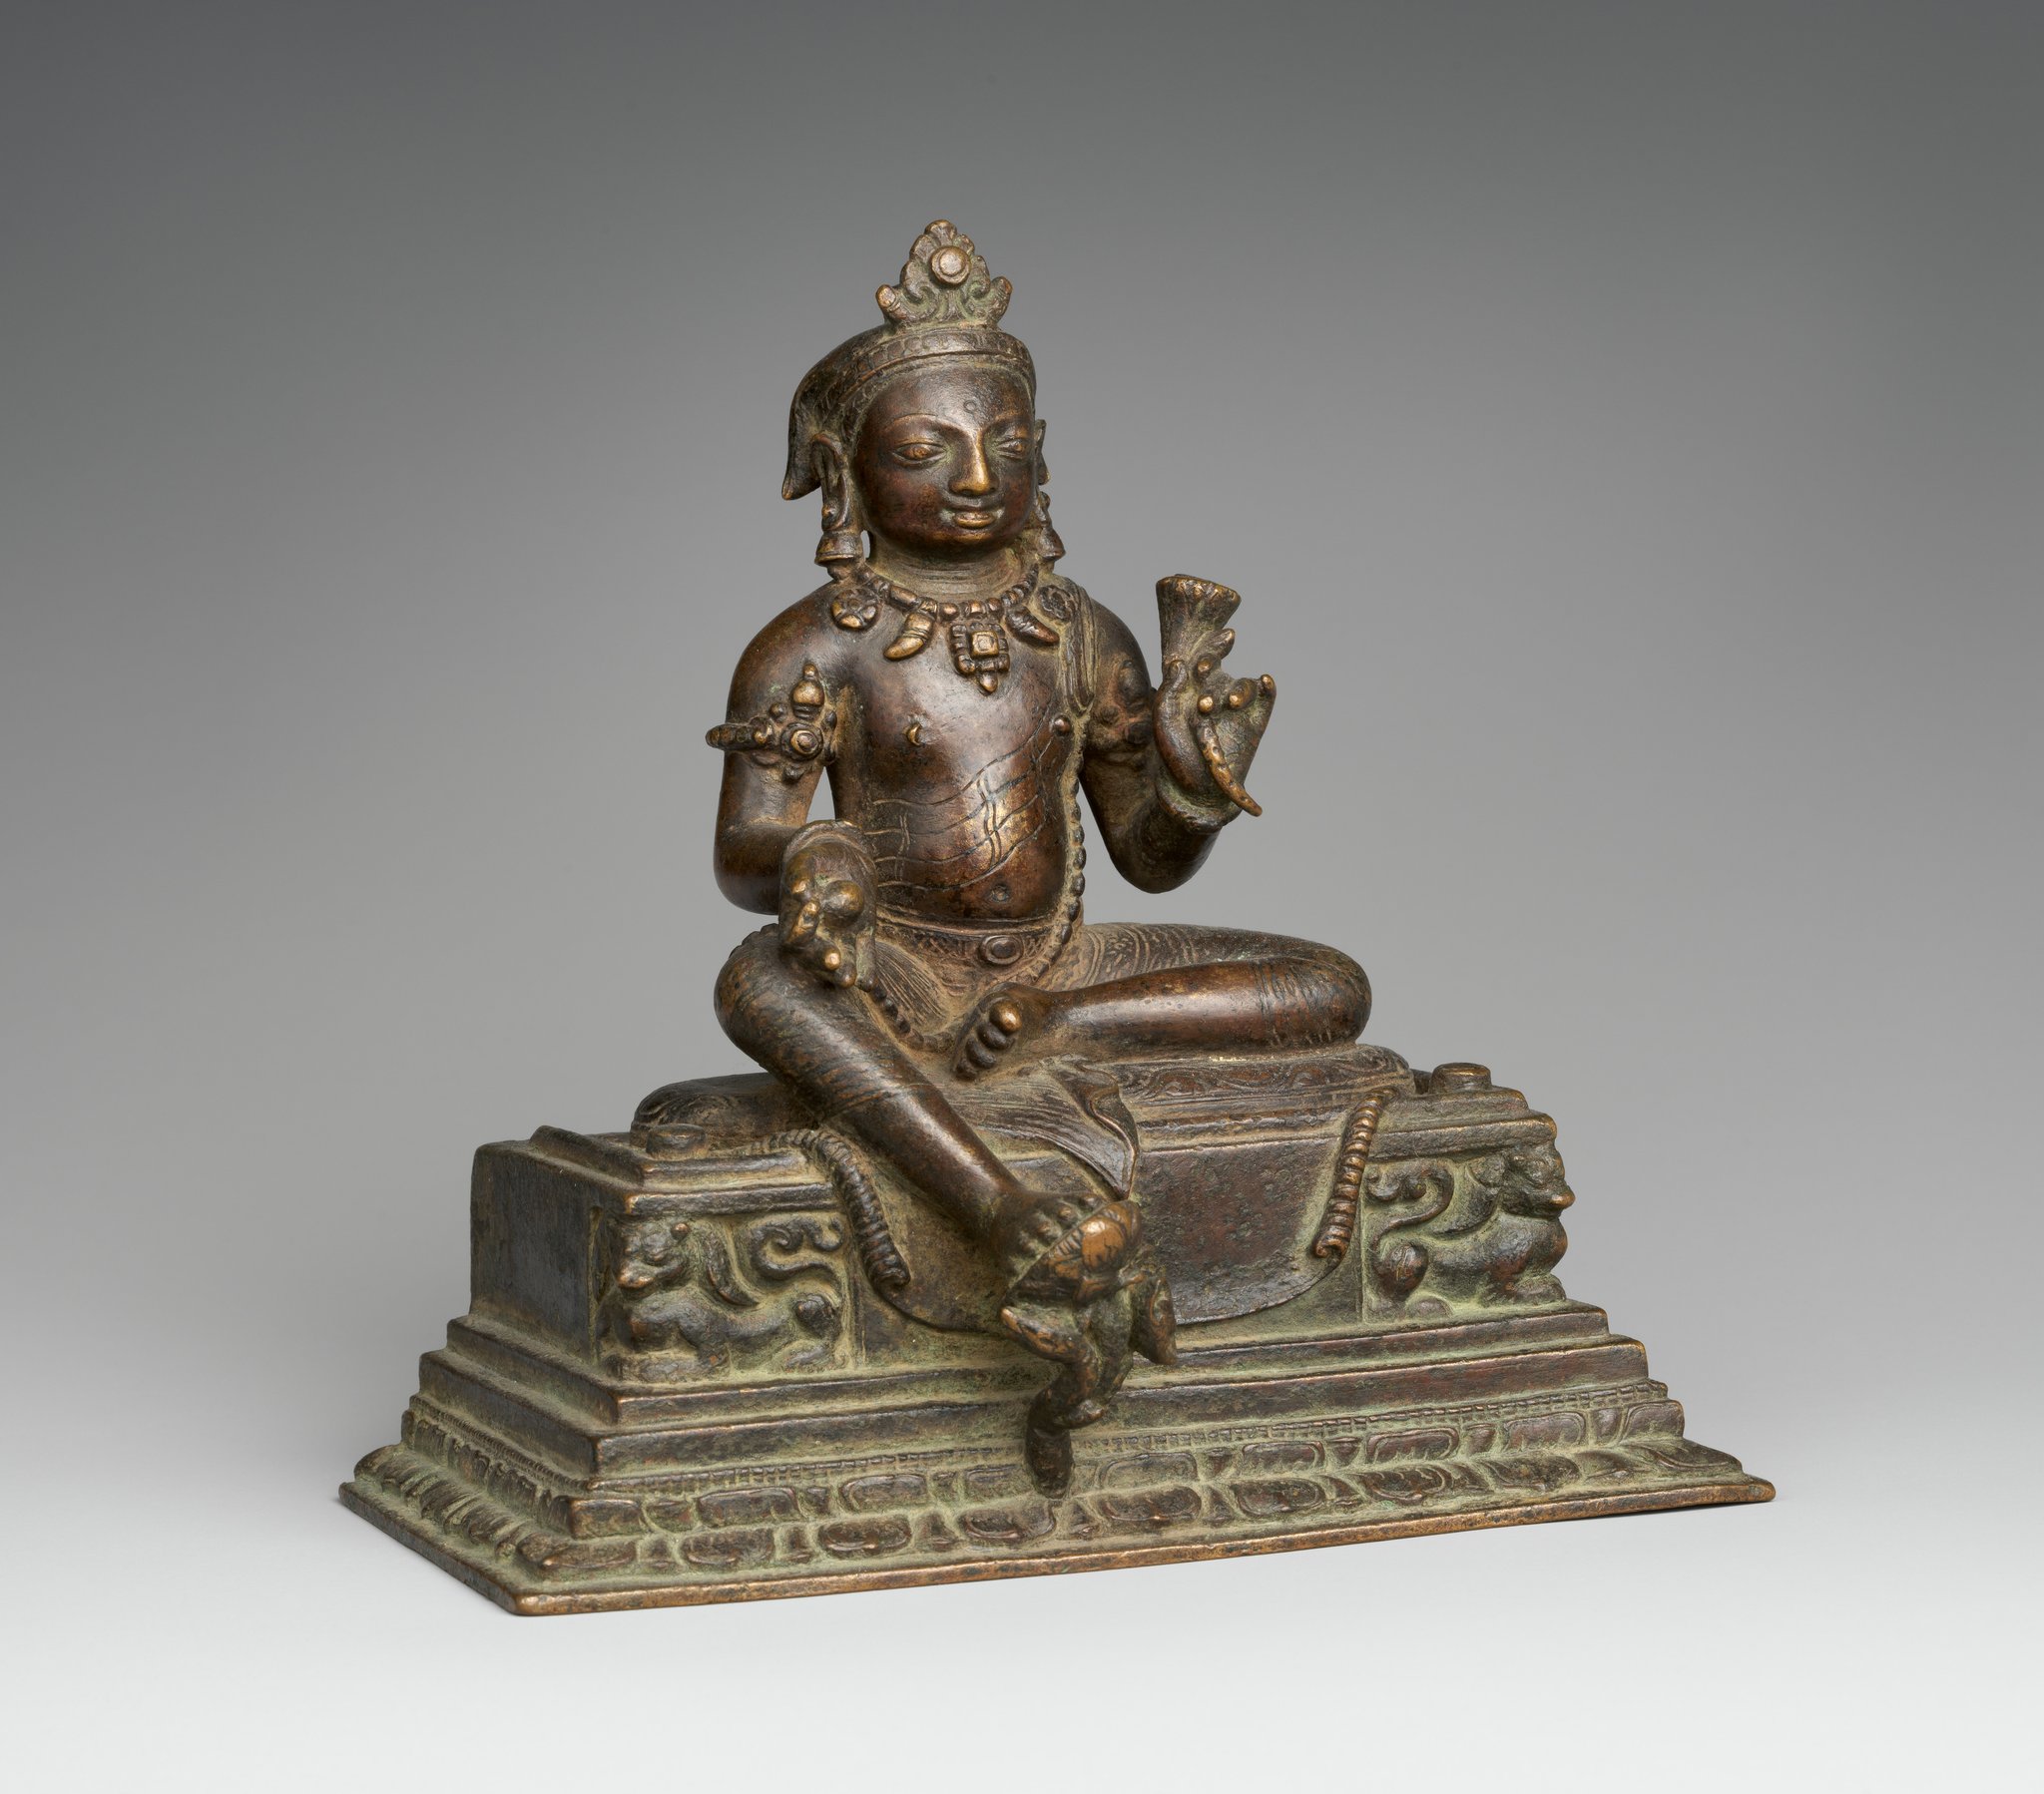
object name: statuette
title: The Bodhisattva Manjushri as a Youth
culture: nepali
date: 901-1000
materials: copper alloy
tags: buddhism,bodhisattvas,manjushri